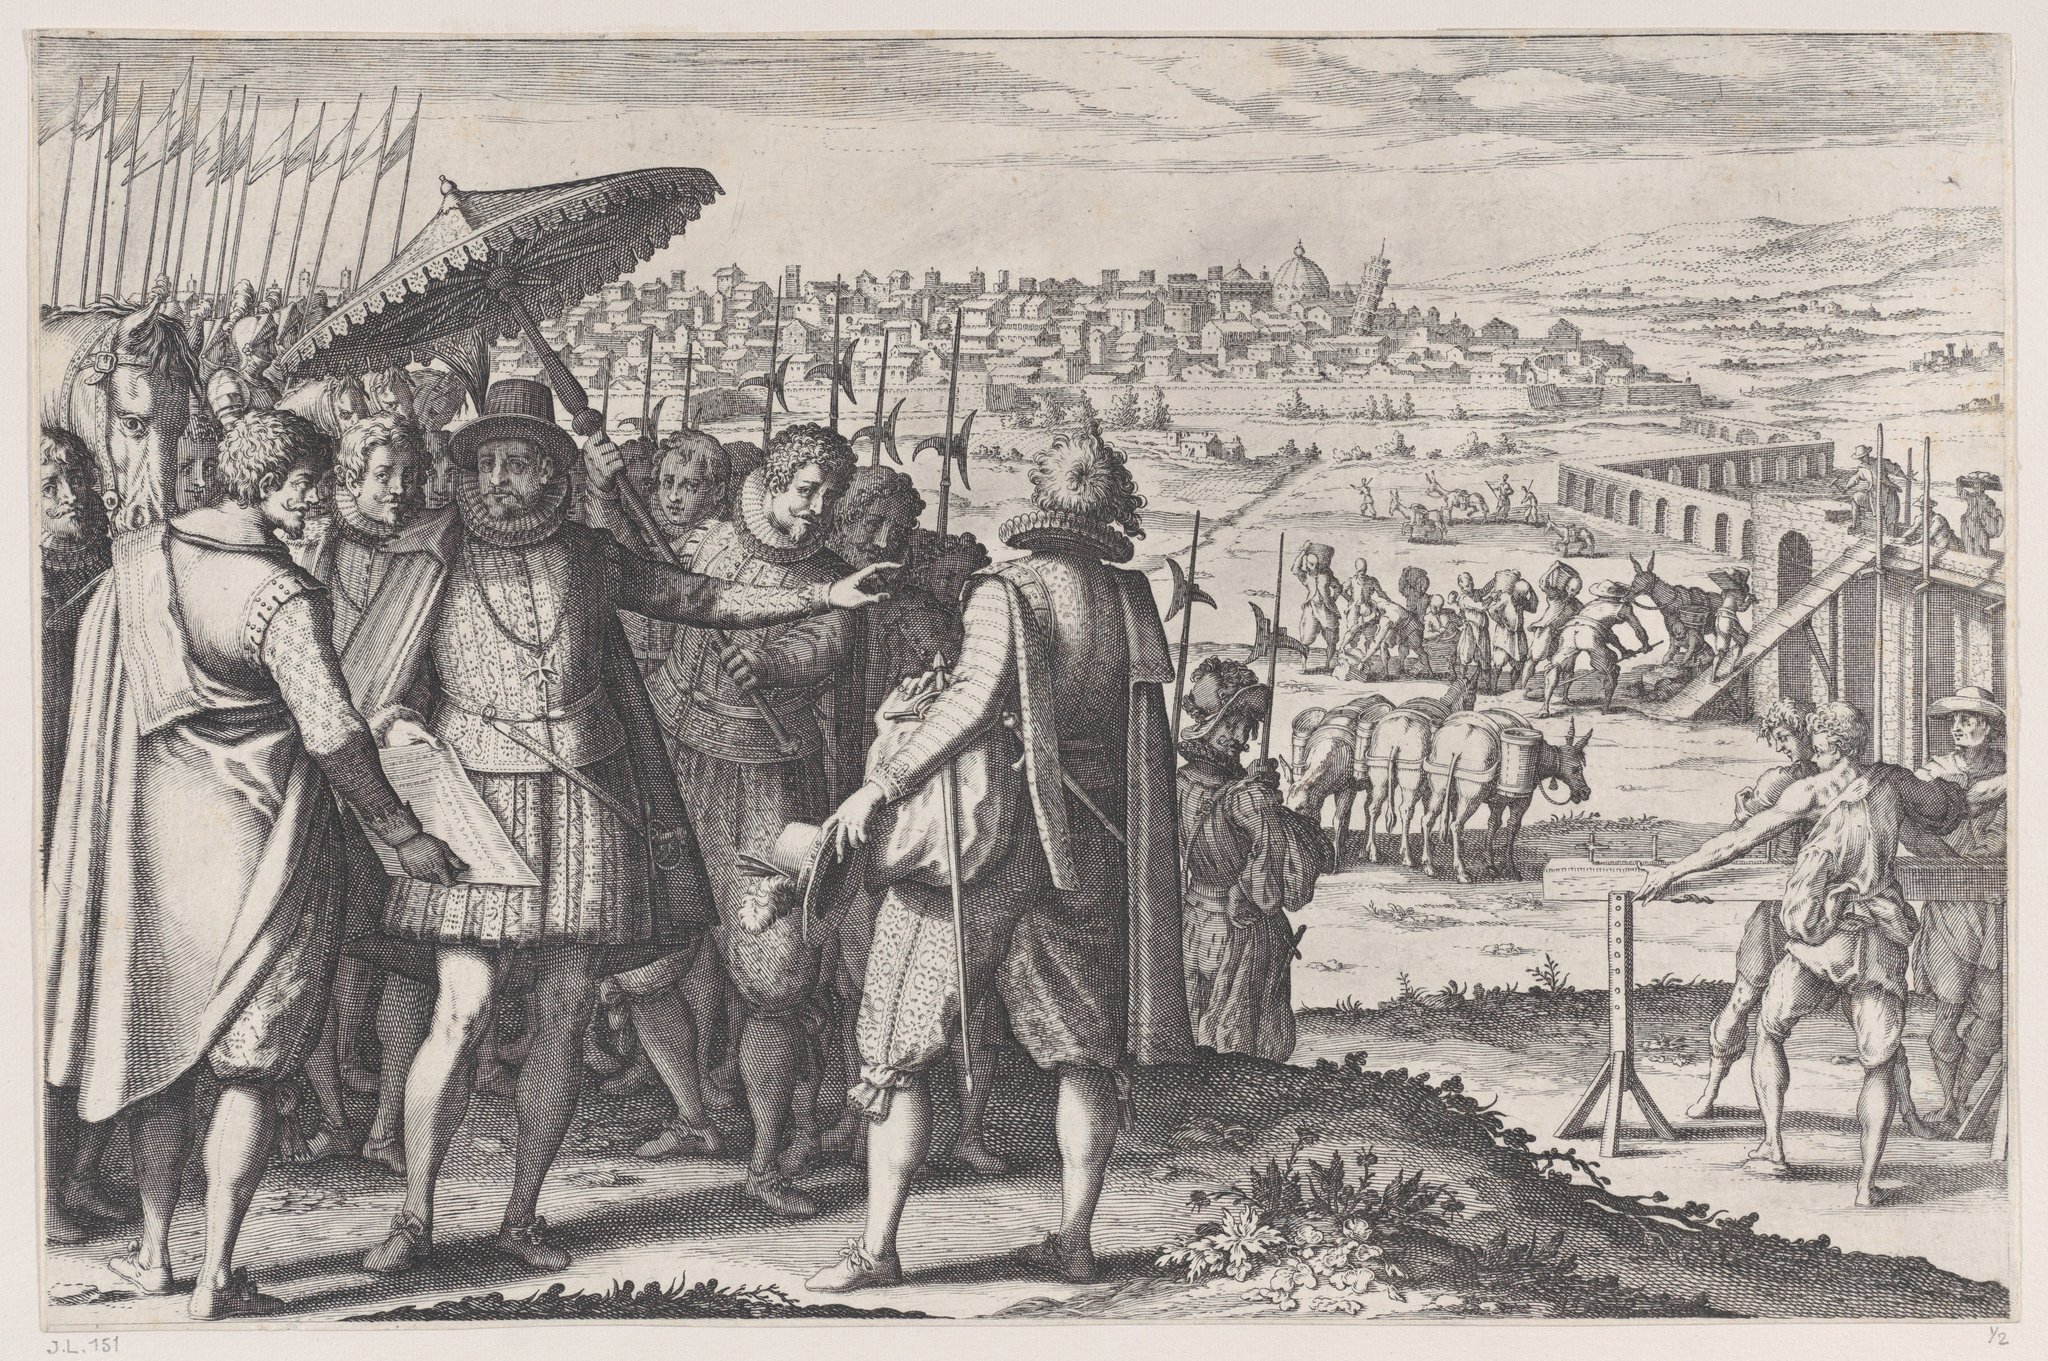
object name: print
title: Restauration de L'Aqueduc de Pise (Restoring the Aqueduct in Pisa), from "La Vie de Ferdinand Ier de Médicis série appelée aussi Les Batailles des Médicis" (The Life of Ferdinand I de'Medici also called The Medici Battles)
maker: jacques callot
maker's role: artist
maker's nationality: french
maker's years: 1592-1635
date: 1614-1620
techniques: engraving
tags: men,aqueducts